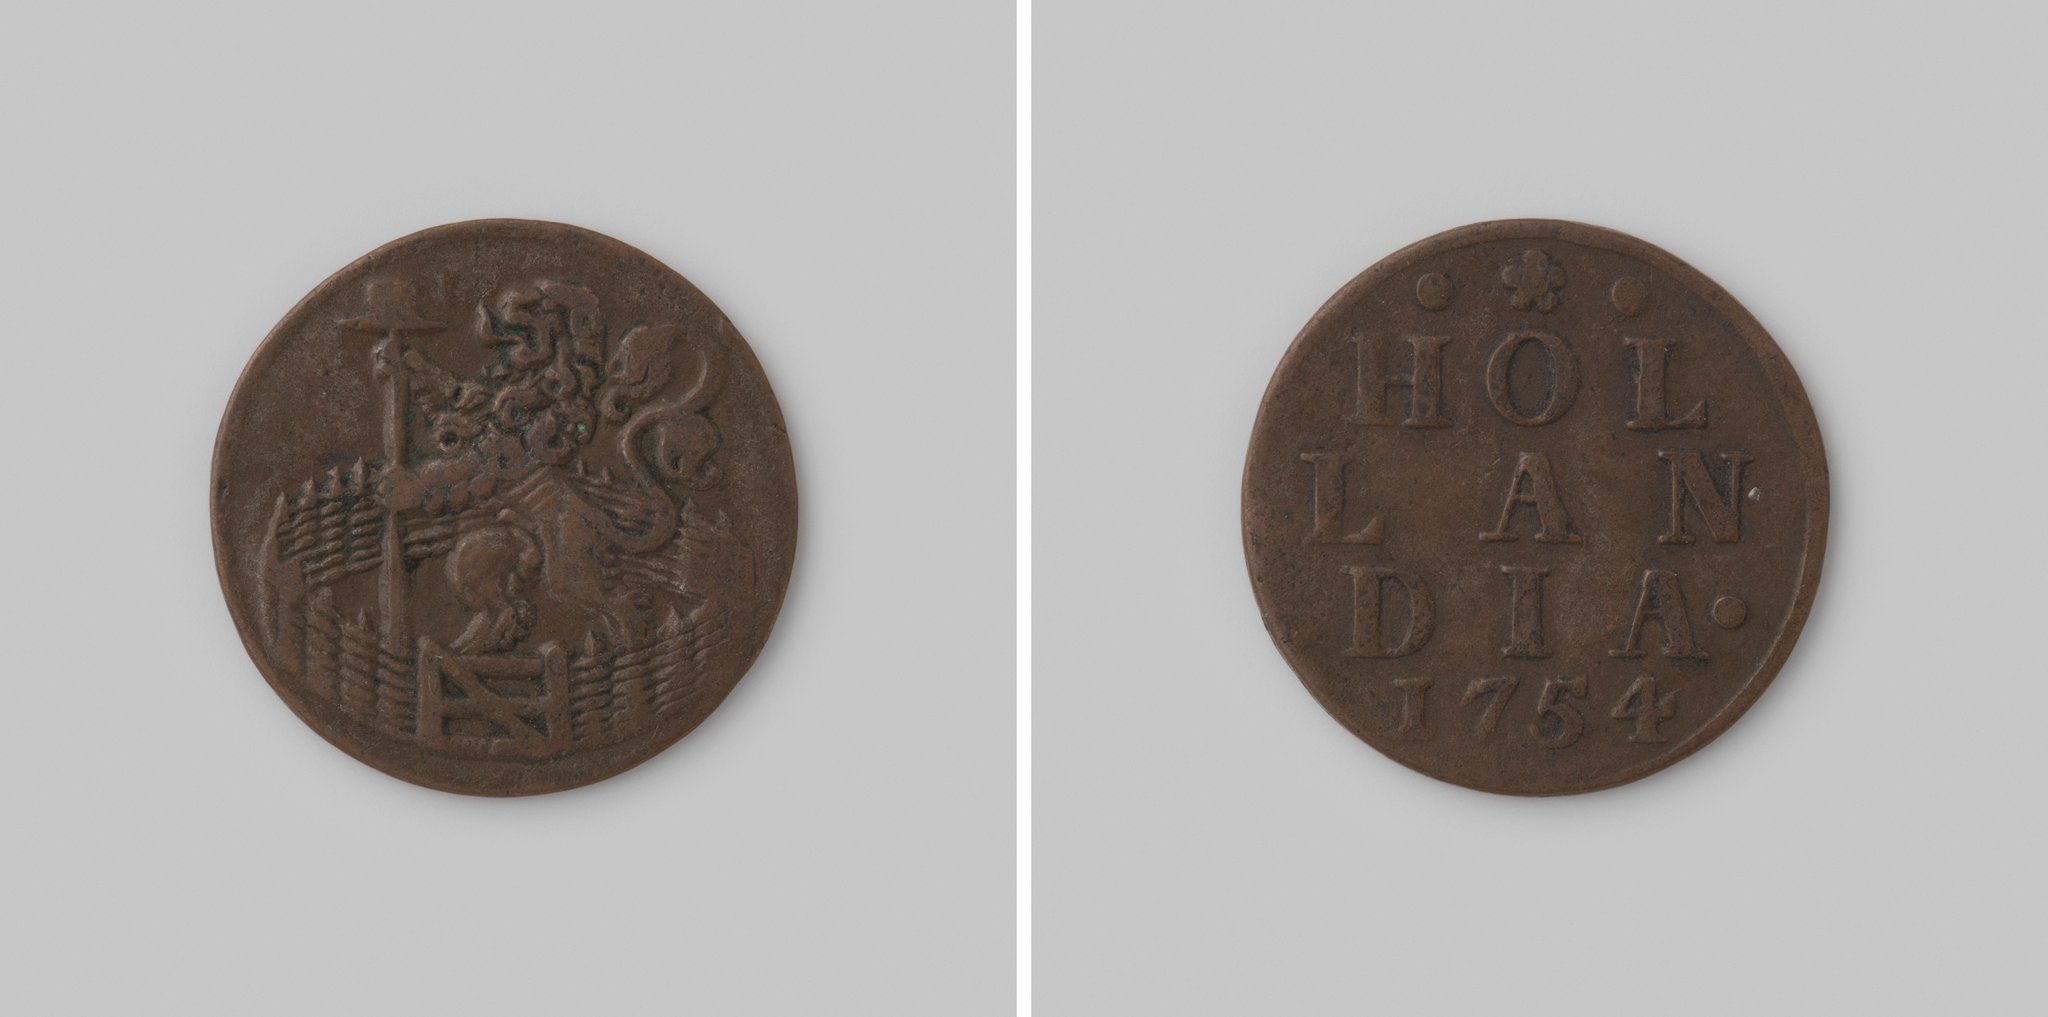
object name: coin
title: Holland, duit, 1754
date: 1754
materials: copper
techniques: striking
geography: dordrecht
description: Koperen munt. Voorzijde: binnen omheining staande leeuw met vrijheidshoed op speer. Keerzijde: opschrift: provincienaam in drie regels, daaronder jaartal.